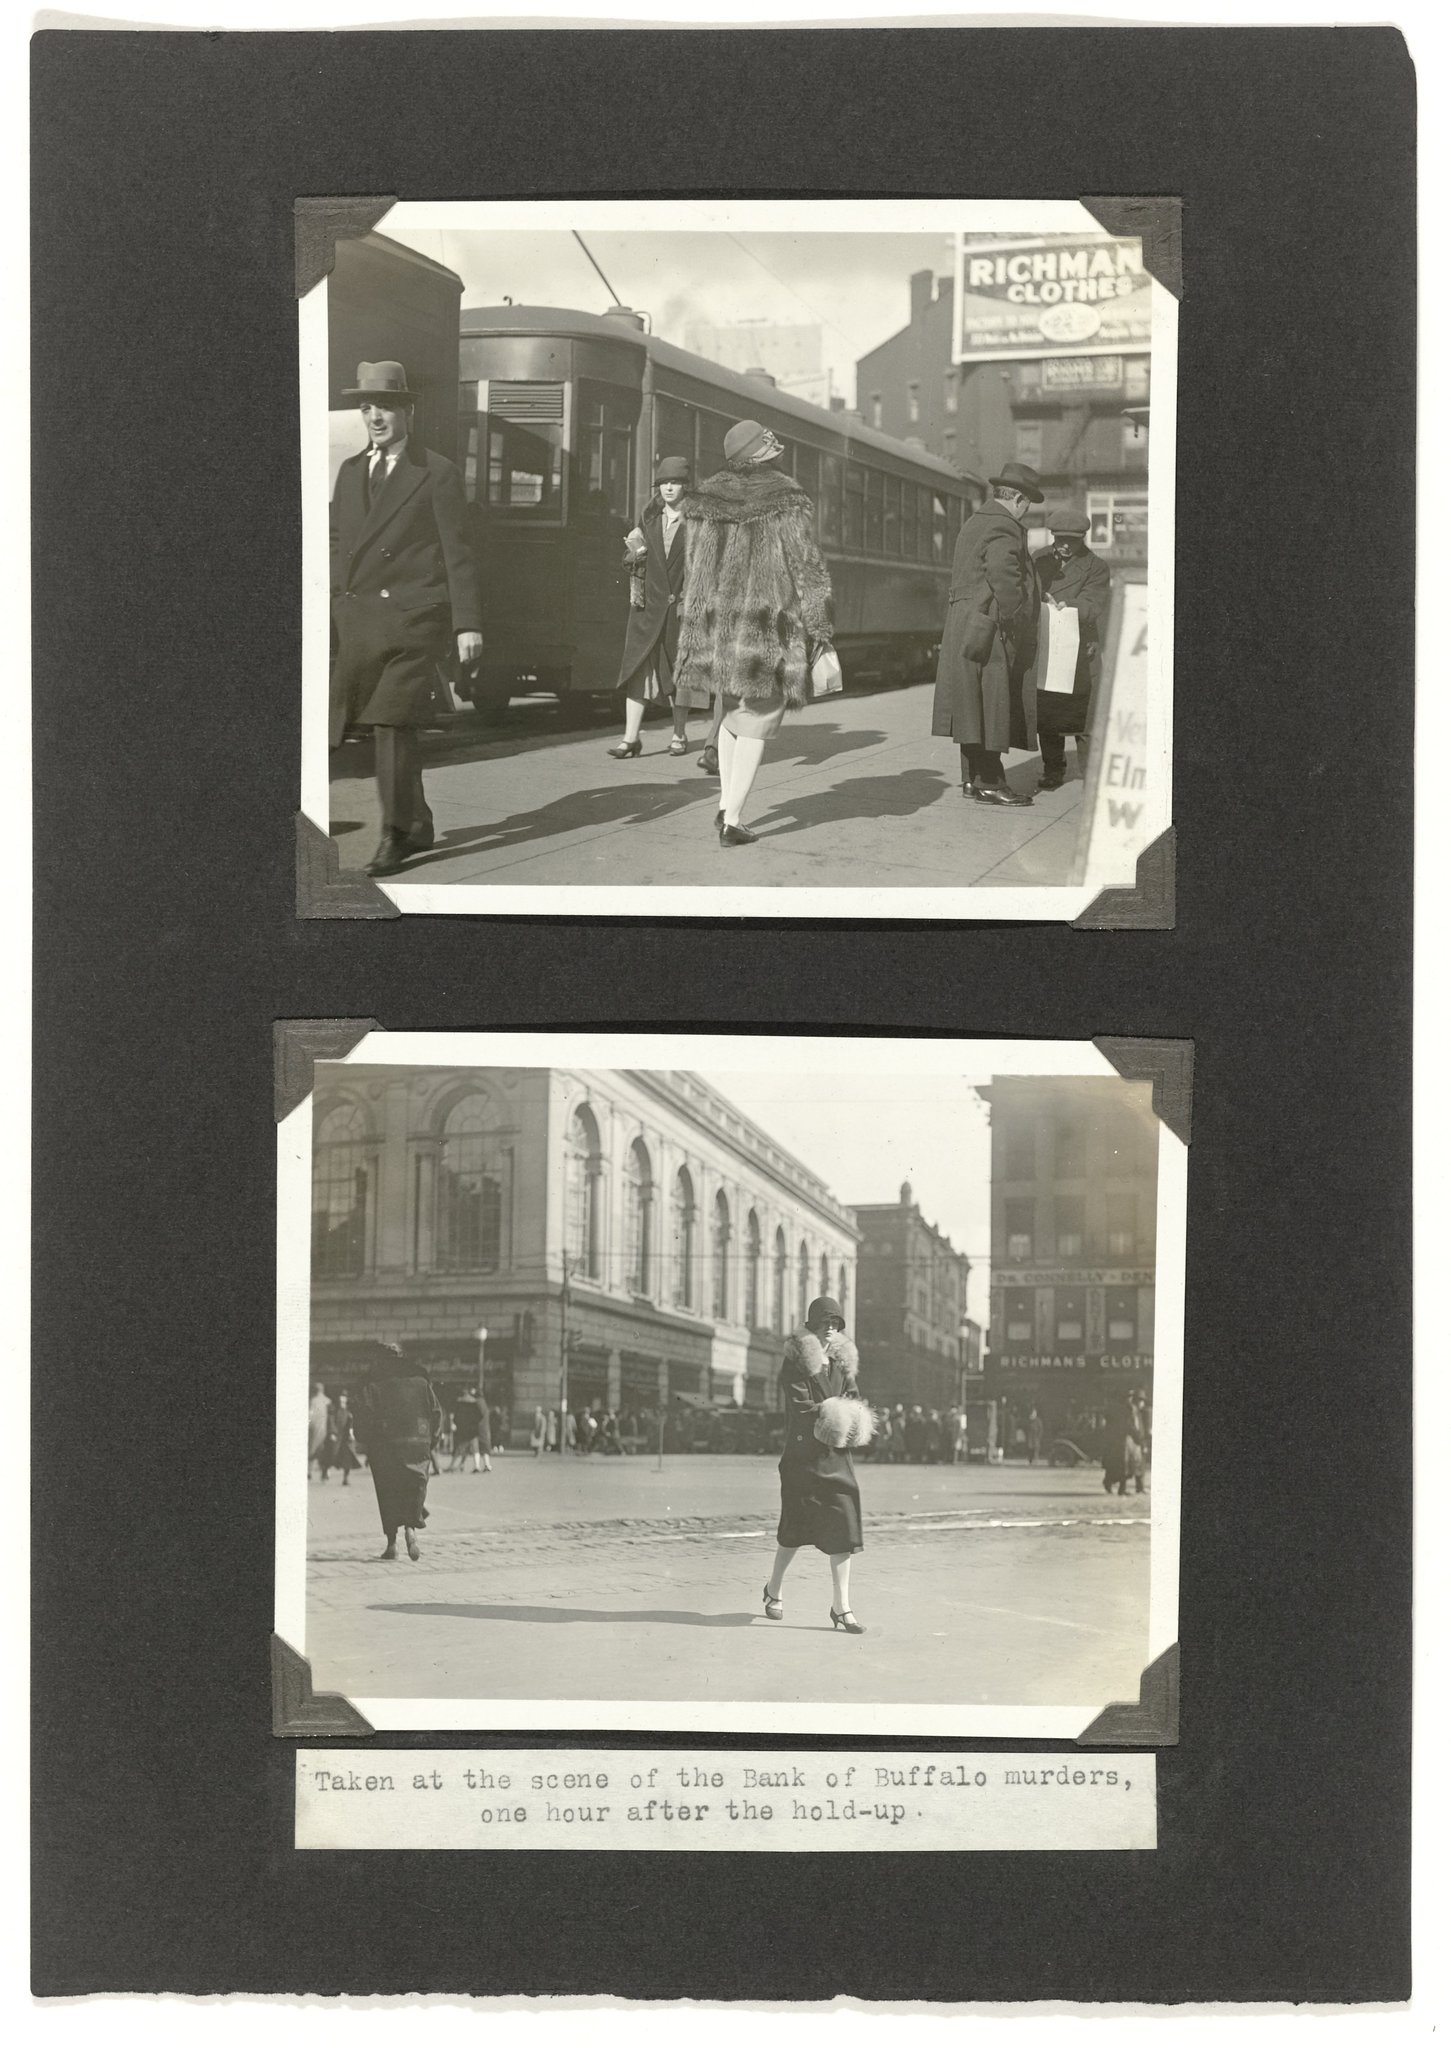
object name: album leaf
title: Albumblad met twee foto's van vrouwen op straat in New York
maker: Anonymous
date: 1926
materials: paper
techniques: gelatin silver print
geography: new york city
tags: street, new york (city)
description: Albumblad met twee foto's van vrouwen op straat.